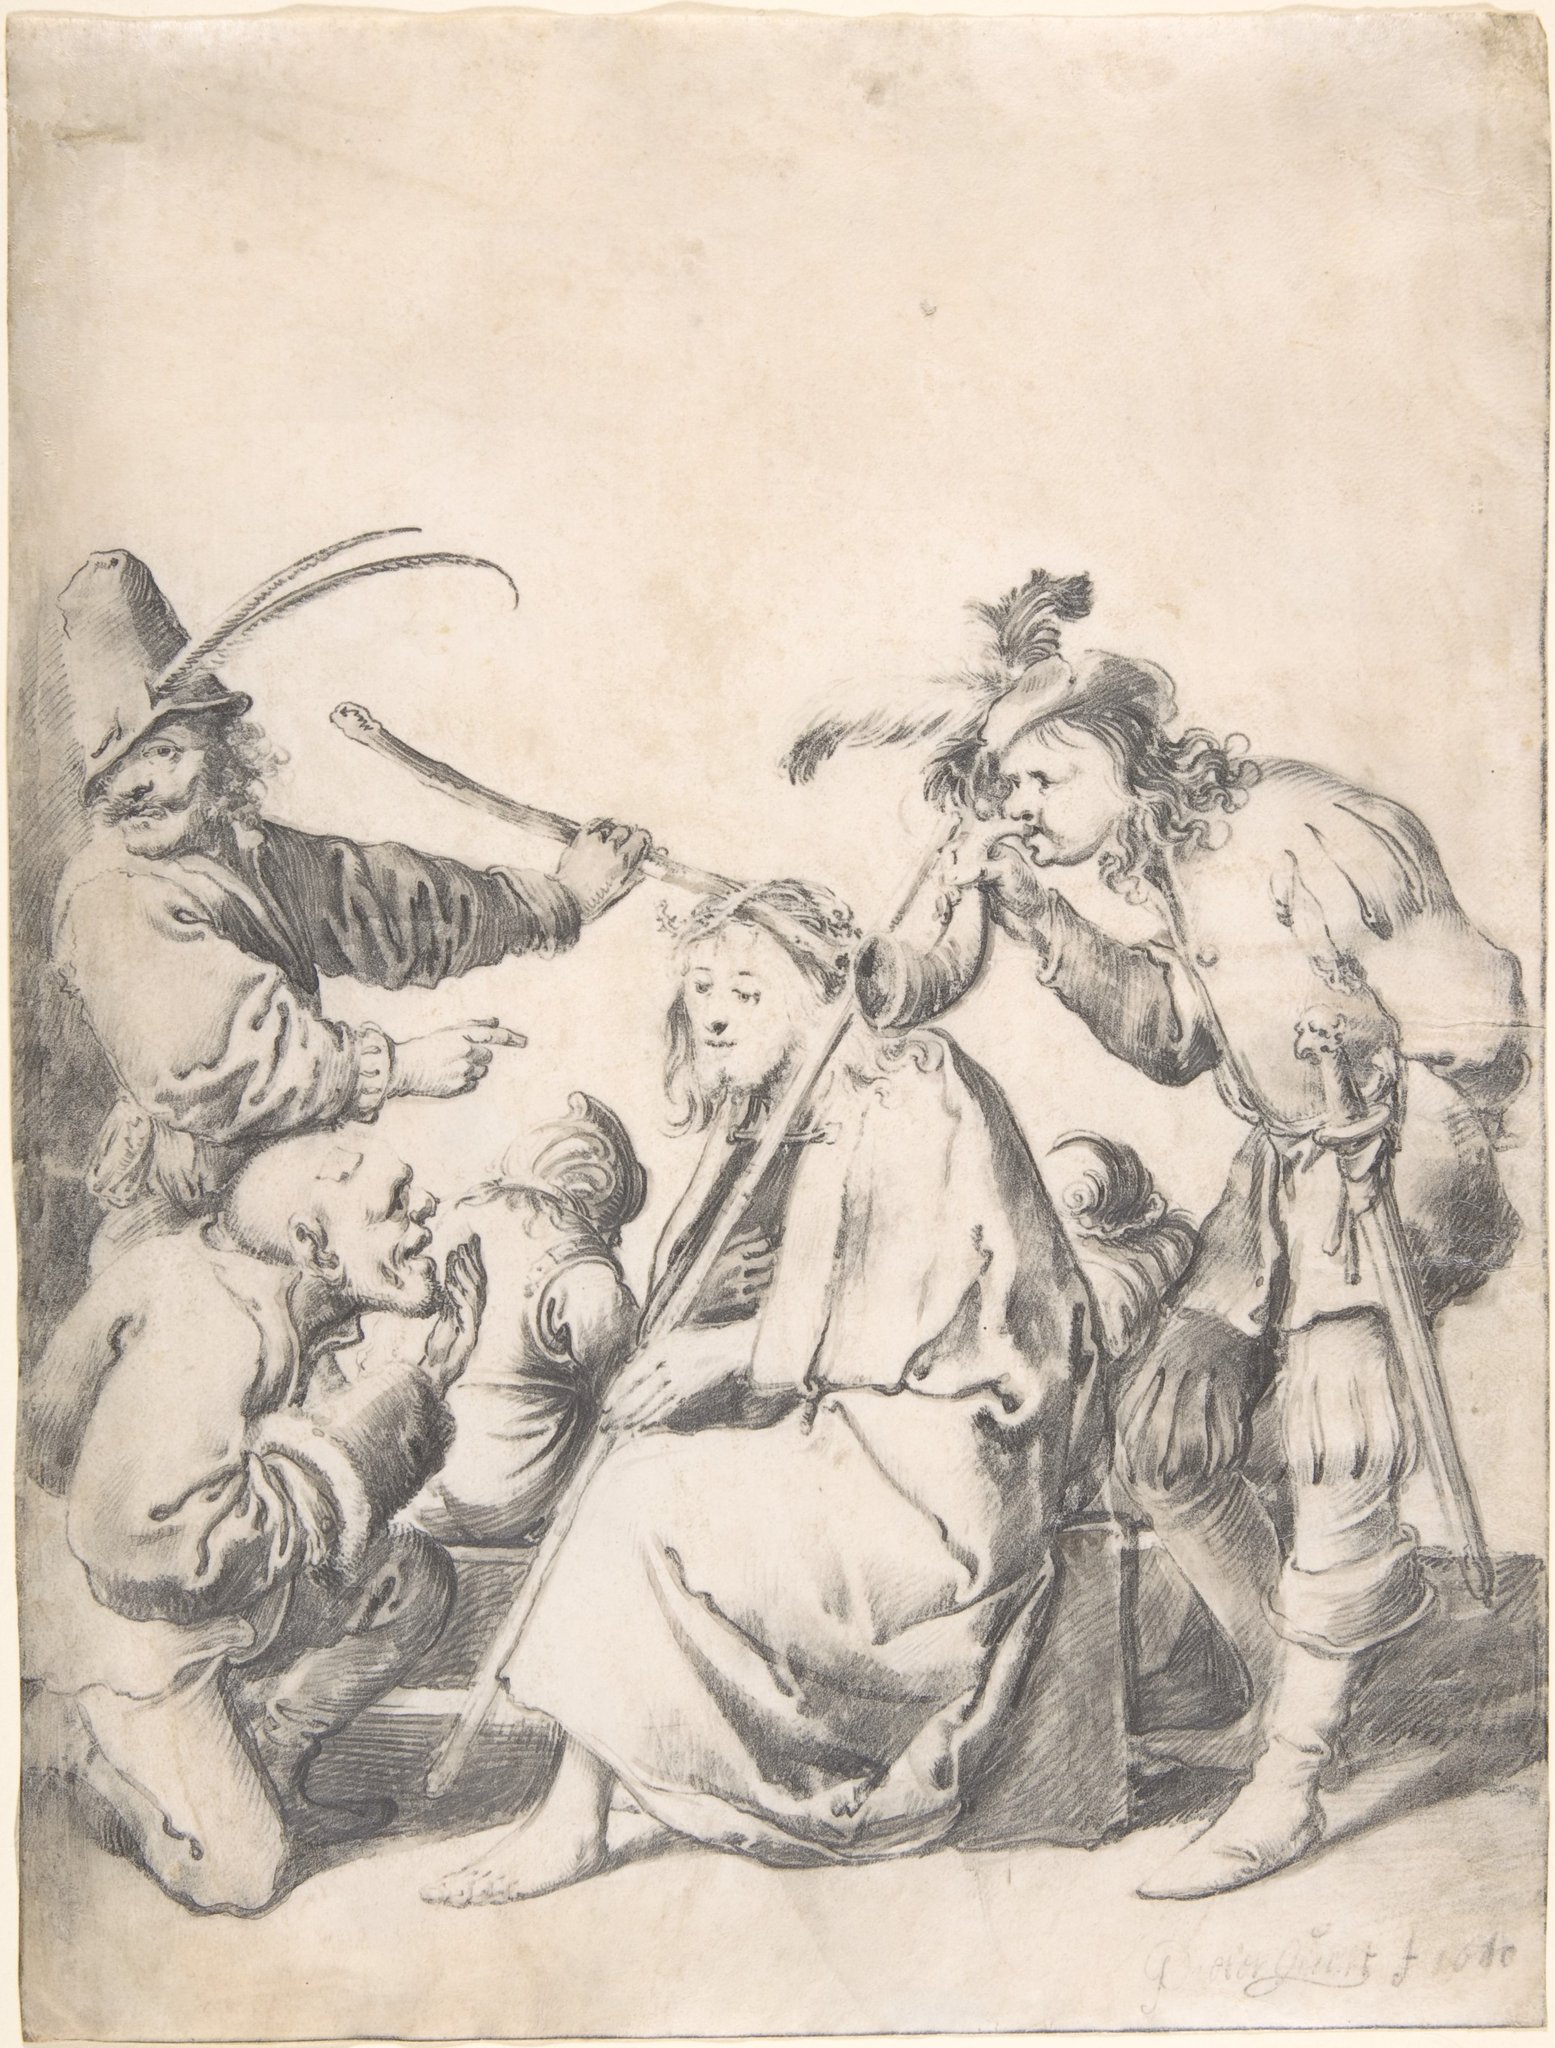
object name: drawing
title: The Mocking of Christ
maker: pieter jansz quast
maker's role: artist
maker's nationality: dutch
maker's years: 1605-1647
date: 1640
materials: chalk, graphite, parchment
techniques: brush, wash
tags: swords,men,christ